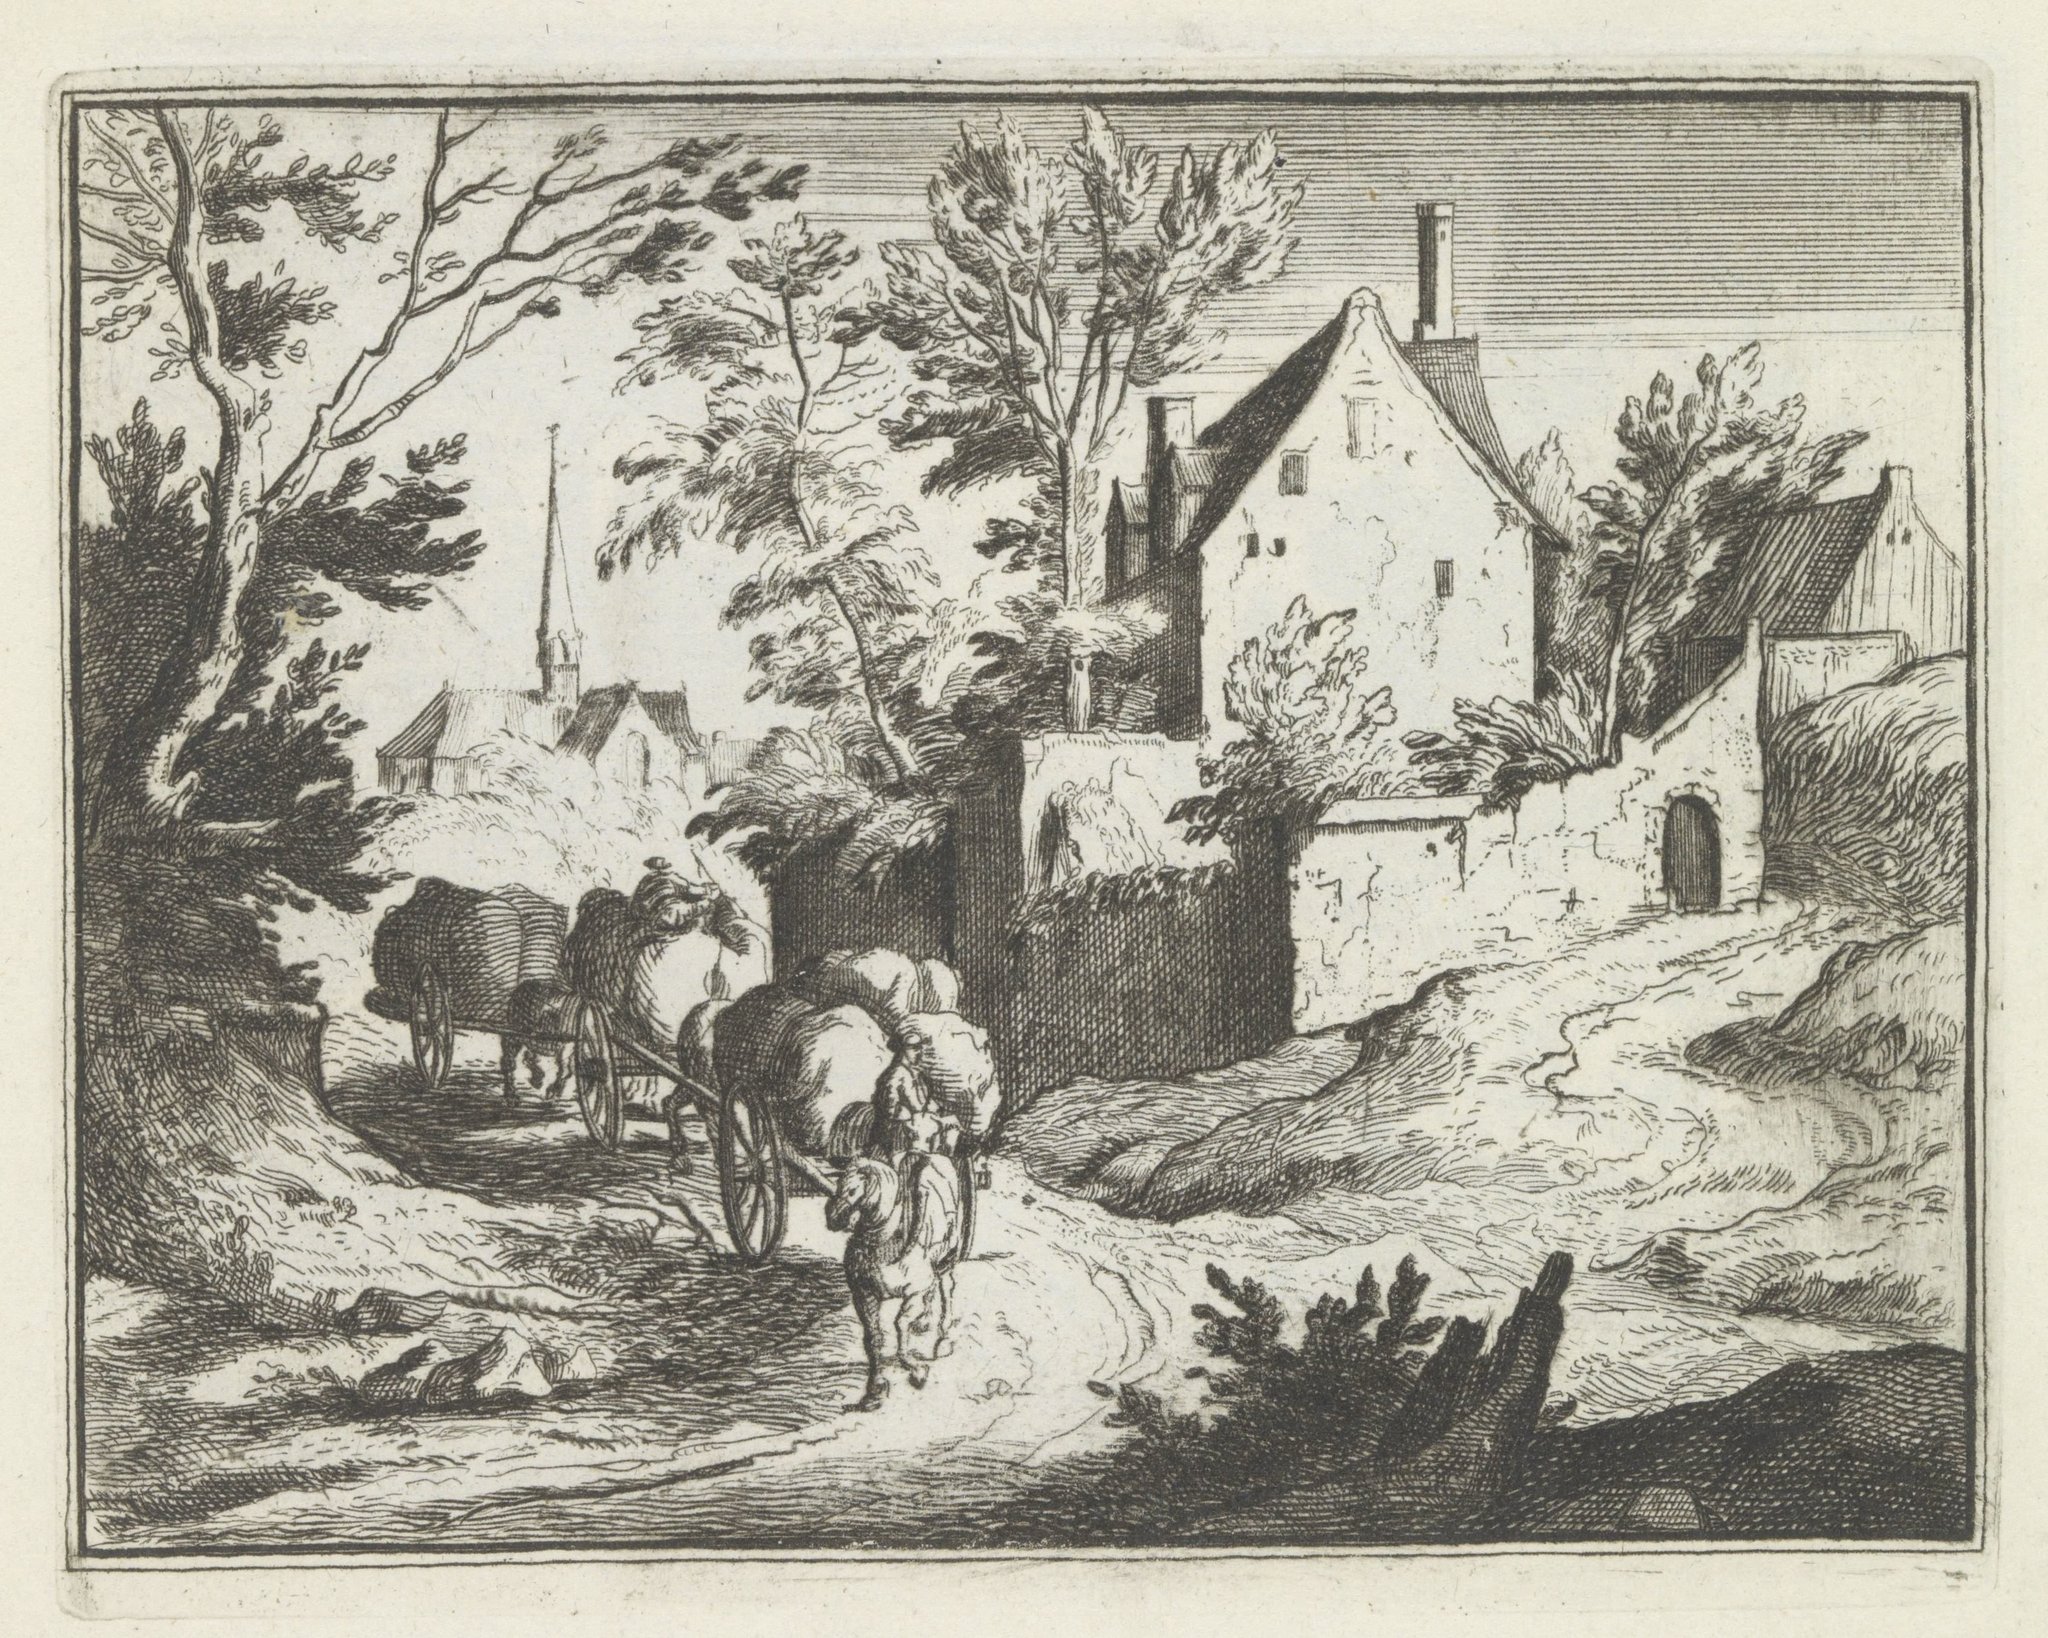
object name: album leaf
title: Spiegel der natuur en school der teekenkunde (...)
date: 1600-1699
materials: paper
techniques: etching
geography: amsterdam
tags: landscapes in the temperate zone, four-wheeled, animal-drawn vehicle, e.g.: cab, carriage, coach, road, path, farm or solitary house in landscape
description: Landweg met drie door paarden getrokken wagens die enkele stenen gebouwen passeren. In de verte een kerk. De prent maakt deel uit van een album.